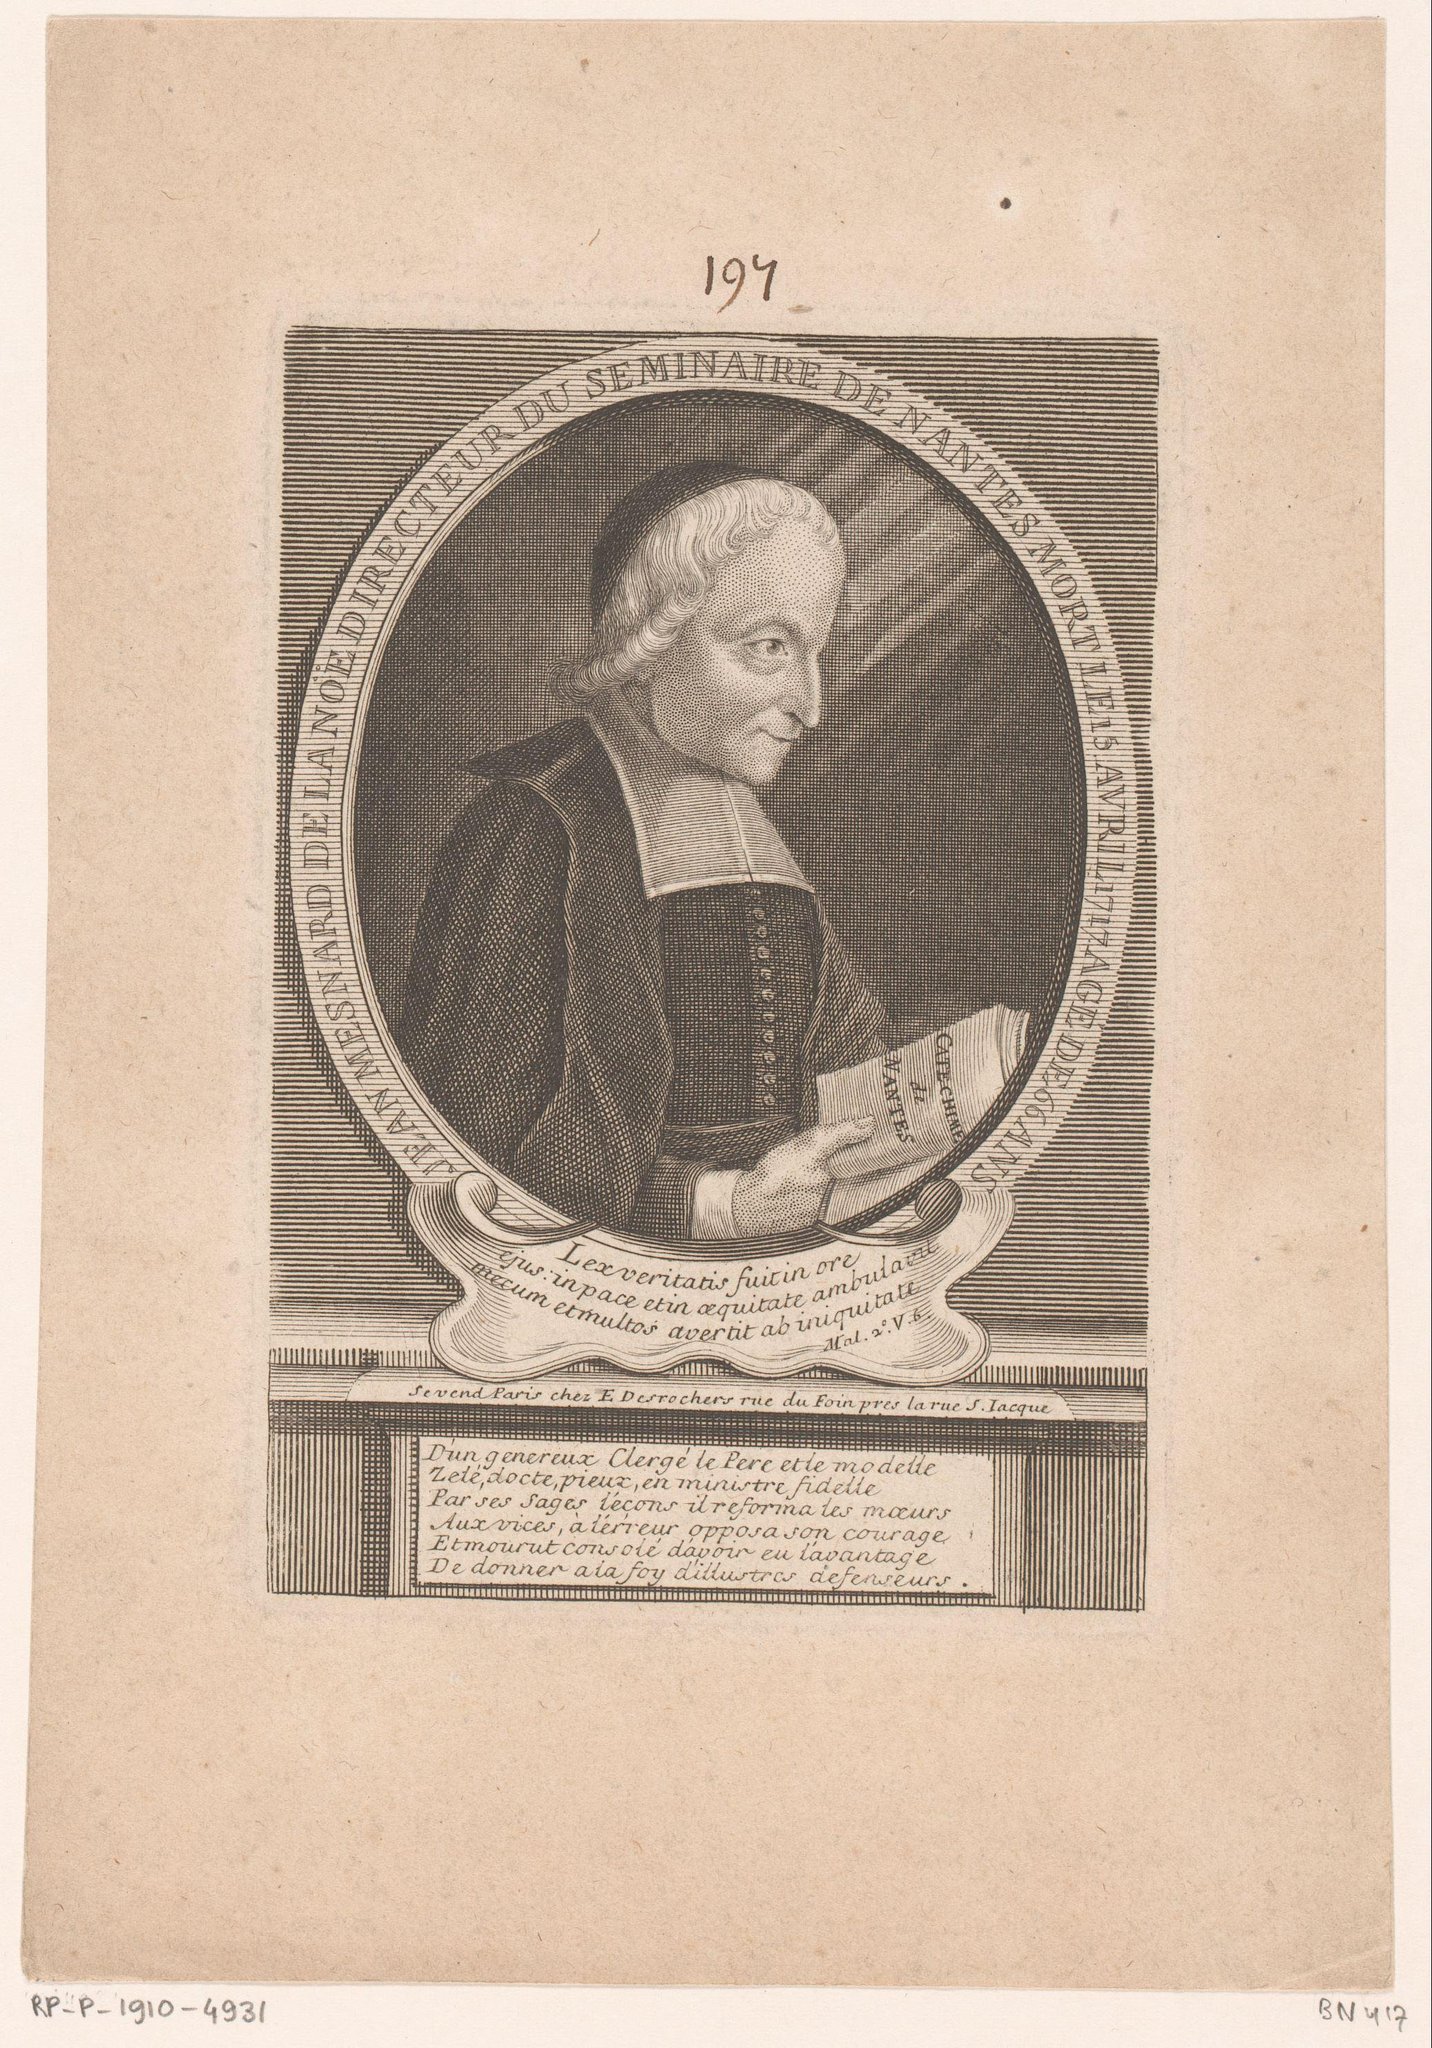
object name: print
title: Verzameling portretten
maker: étienne desrochers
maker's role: print maker, publisher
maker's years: 1668-1741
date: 1726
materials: paper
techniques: engraving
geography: paris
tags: priest, historical persons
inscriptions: collector's mark: Lugt 2228, number: ‘194’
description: Behoort waarschijnlijk tot een serie portretten, grotendeels door Etienne Desrochers, getiteld: 'Recueil de portraits de personnes qui se sont distinguées tant dans les Armes que dans Belles-Lettres et les Arts, comme aussi la famille royale de France et autres cours étrangères'. De serie werd initieel uitgegeven door Desrochers en aangekondigd in 'Mercure' in mei 1726, p. 985. Echter was Desrochers reeds enkele jaren eerder begonnen met het uitgeven van de serie. Na de dood van Desrochers werd de serie voortgezet door Gilles Edme Petit. Een latere staat werd uitgegeven door Jean François Daumont in Parijs.